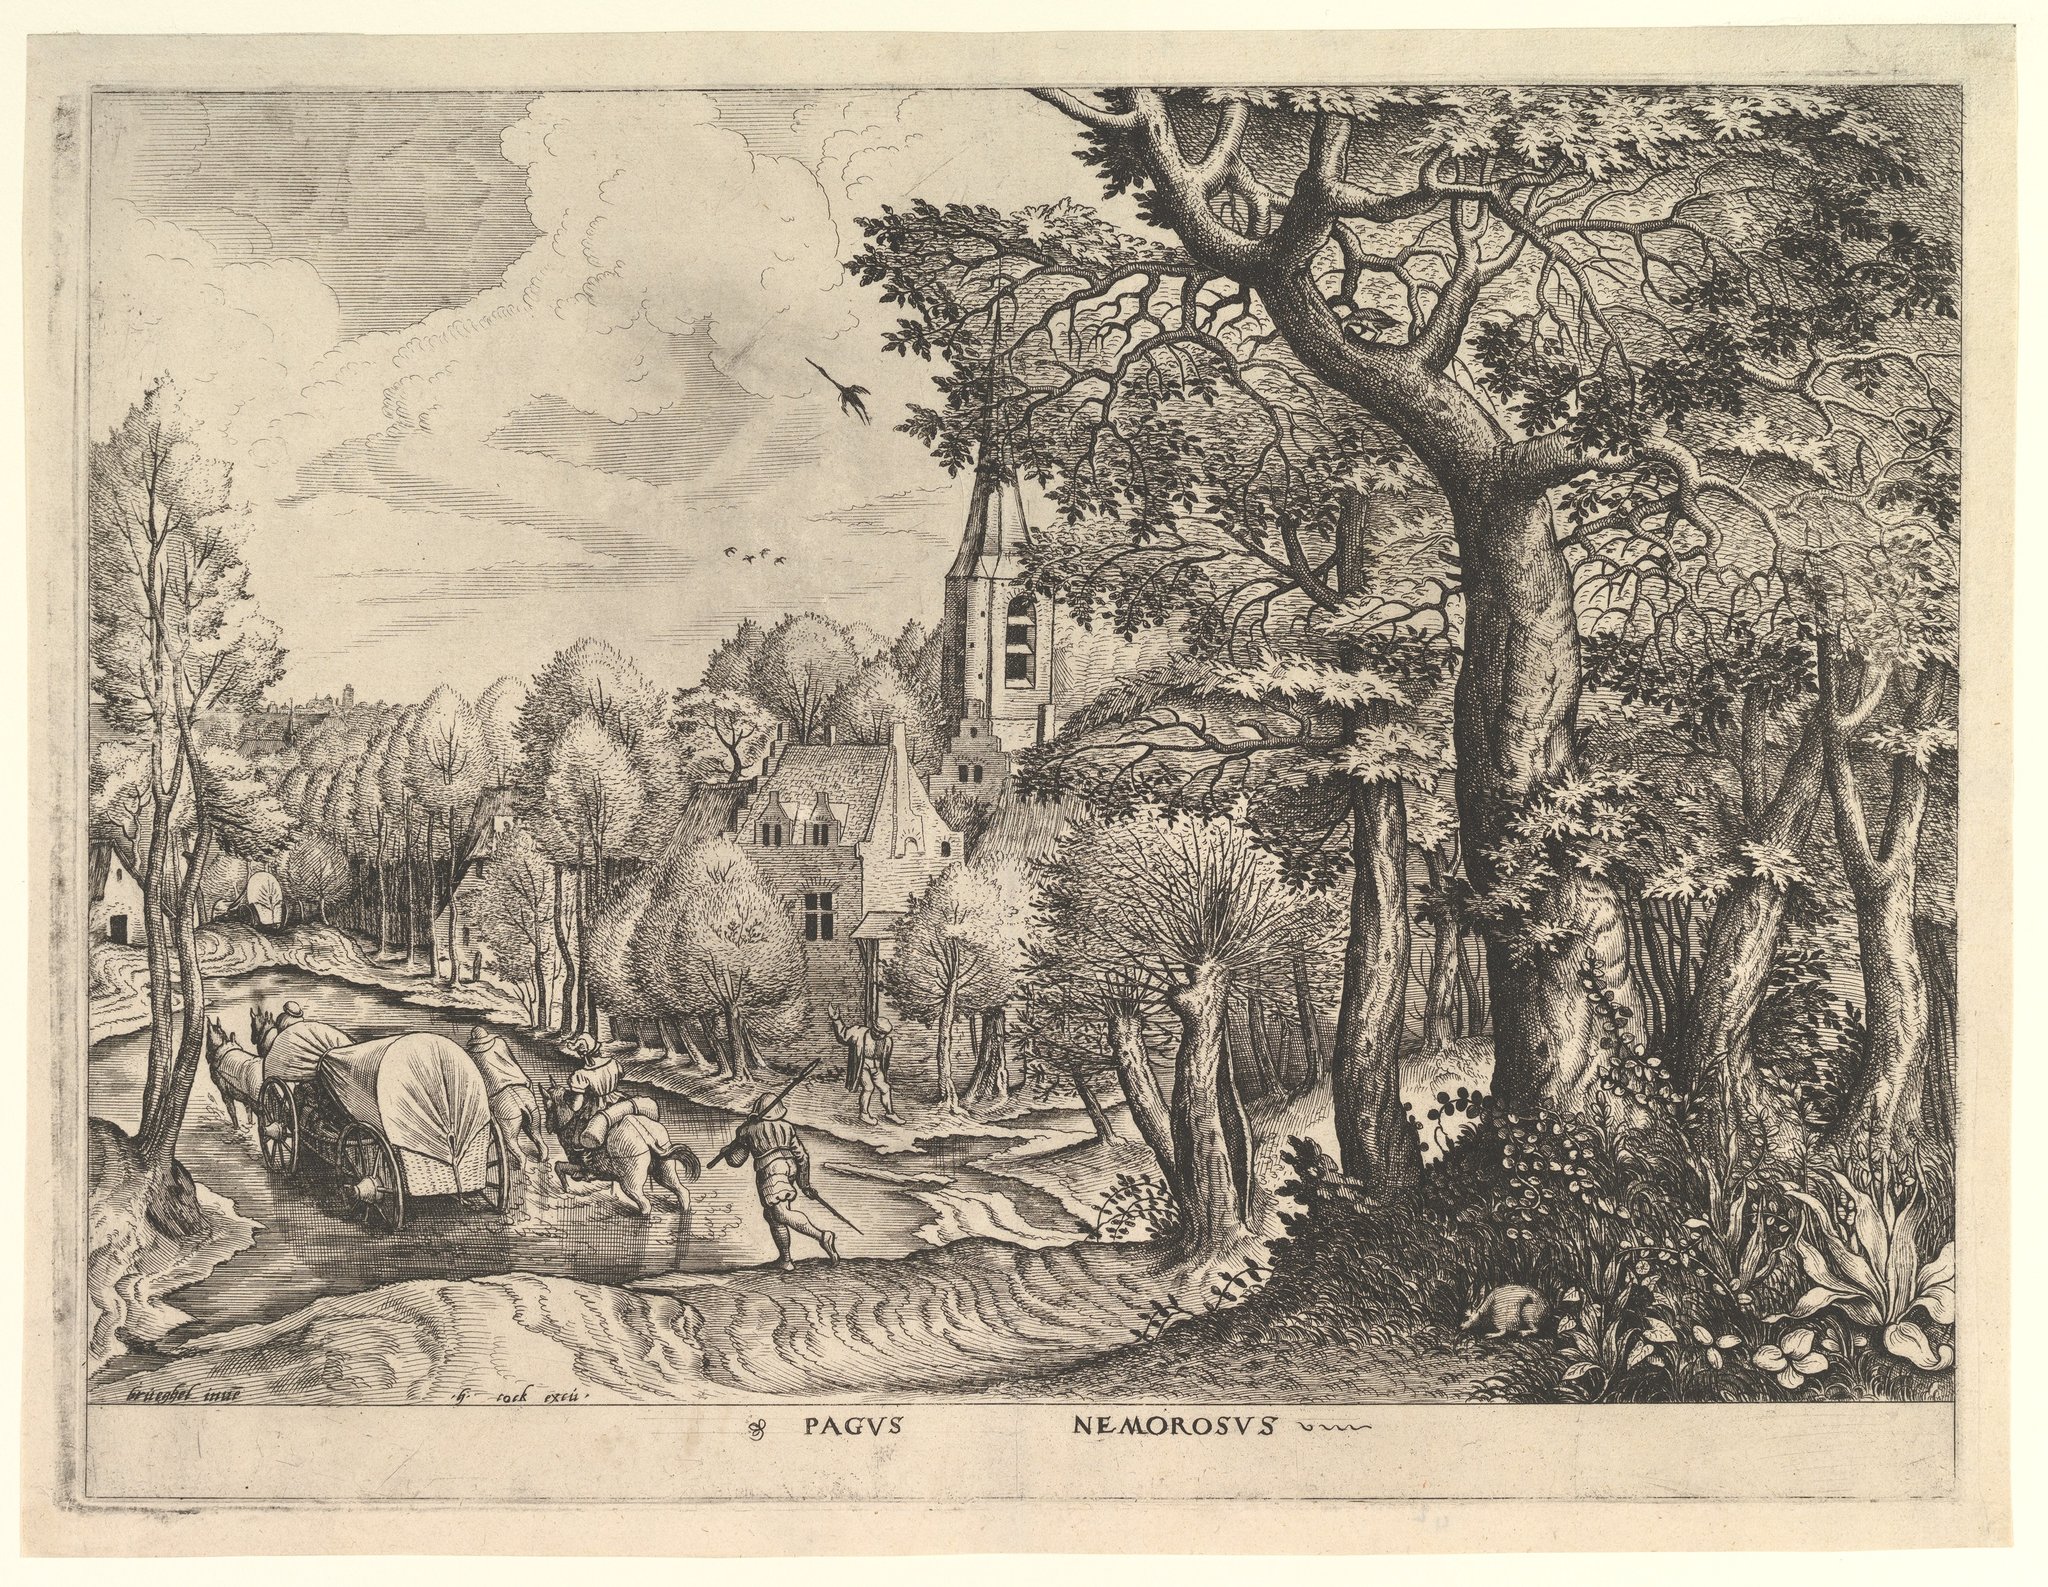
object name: print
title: Wooded Region (Pagus Nemorosus), from "The Large Landscapes"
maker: pieter bruegel the elder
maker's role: artist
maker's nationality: netherlandish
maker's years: 1525-1569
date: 1555-1556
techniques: engraving, etching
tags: men,horses,landscapes,trees,carriages